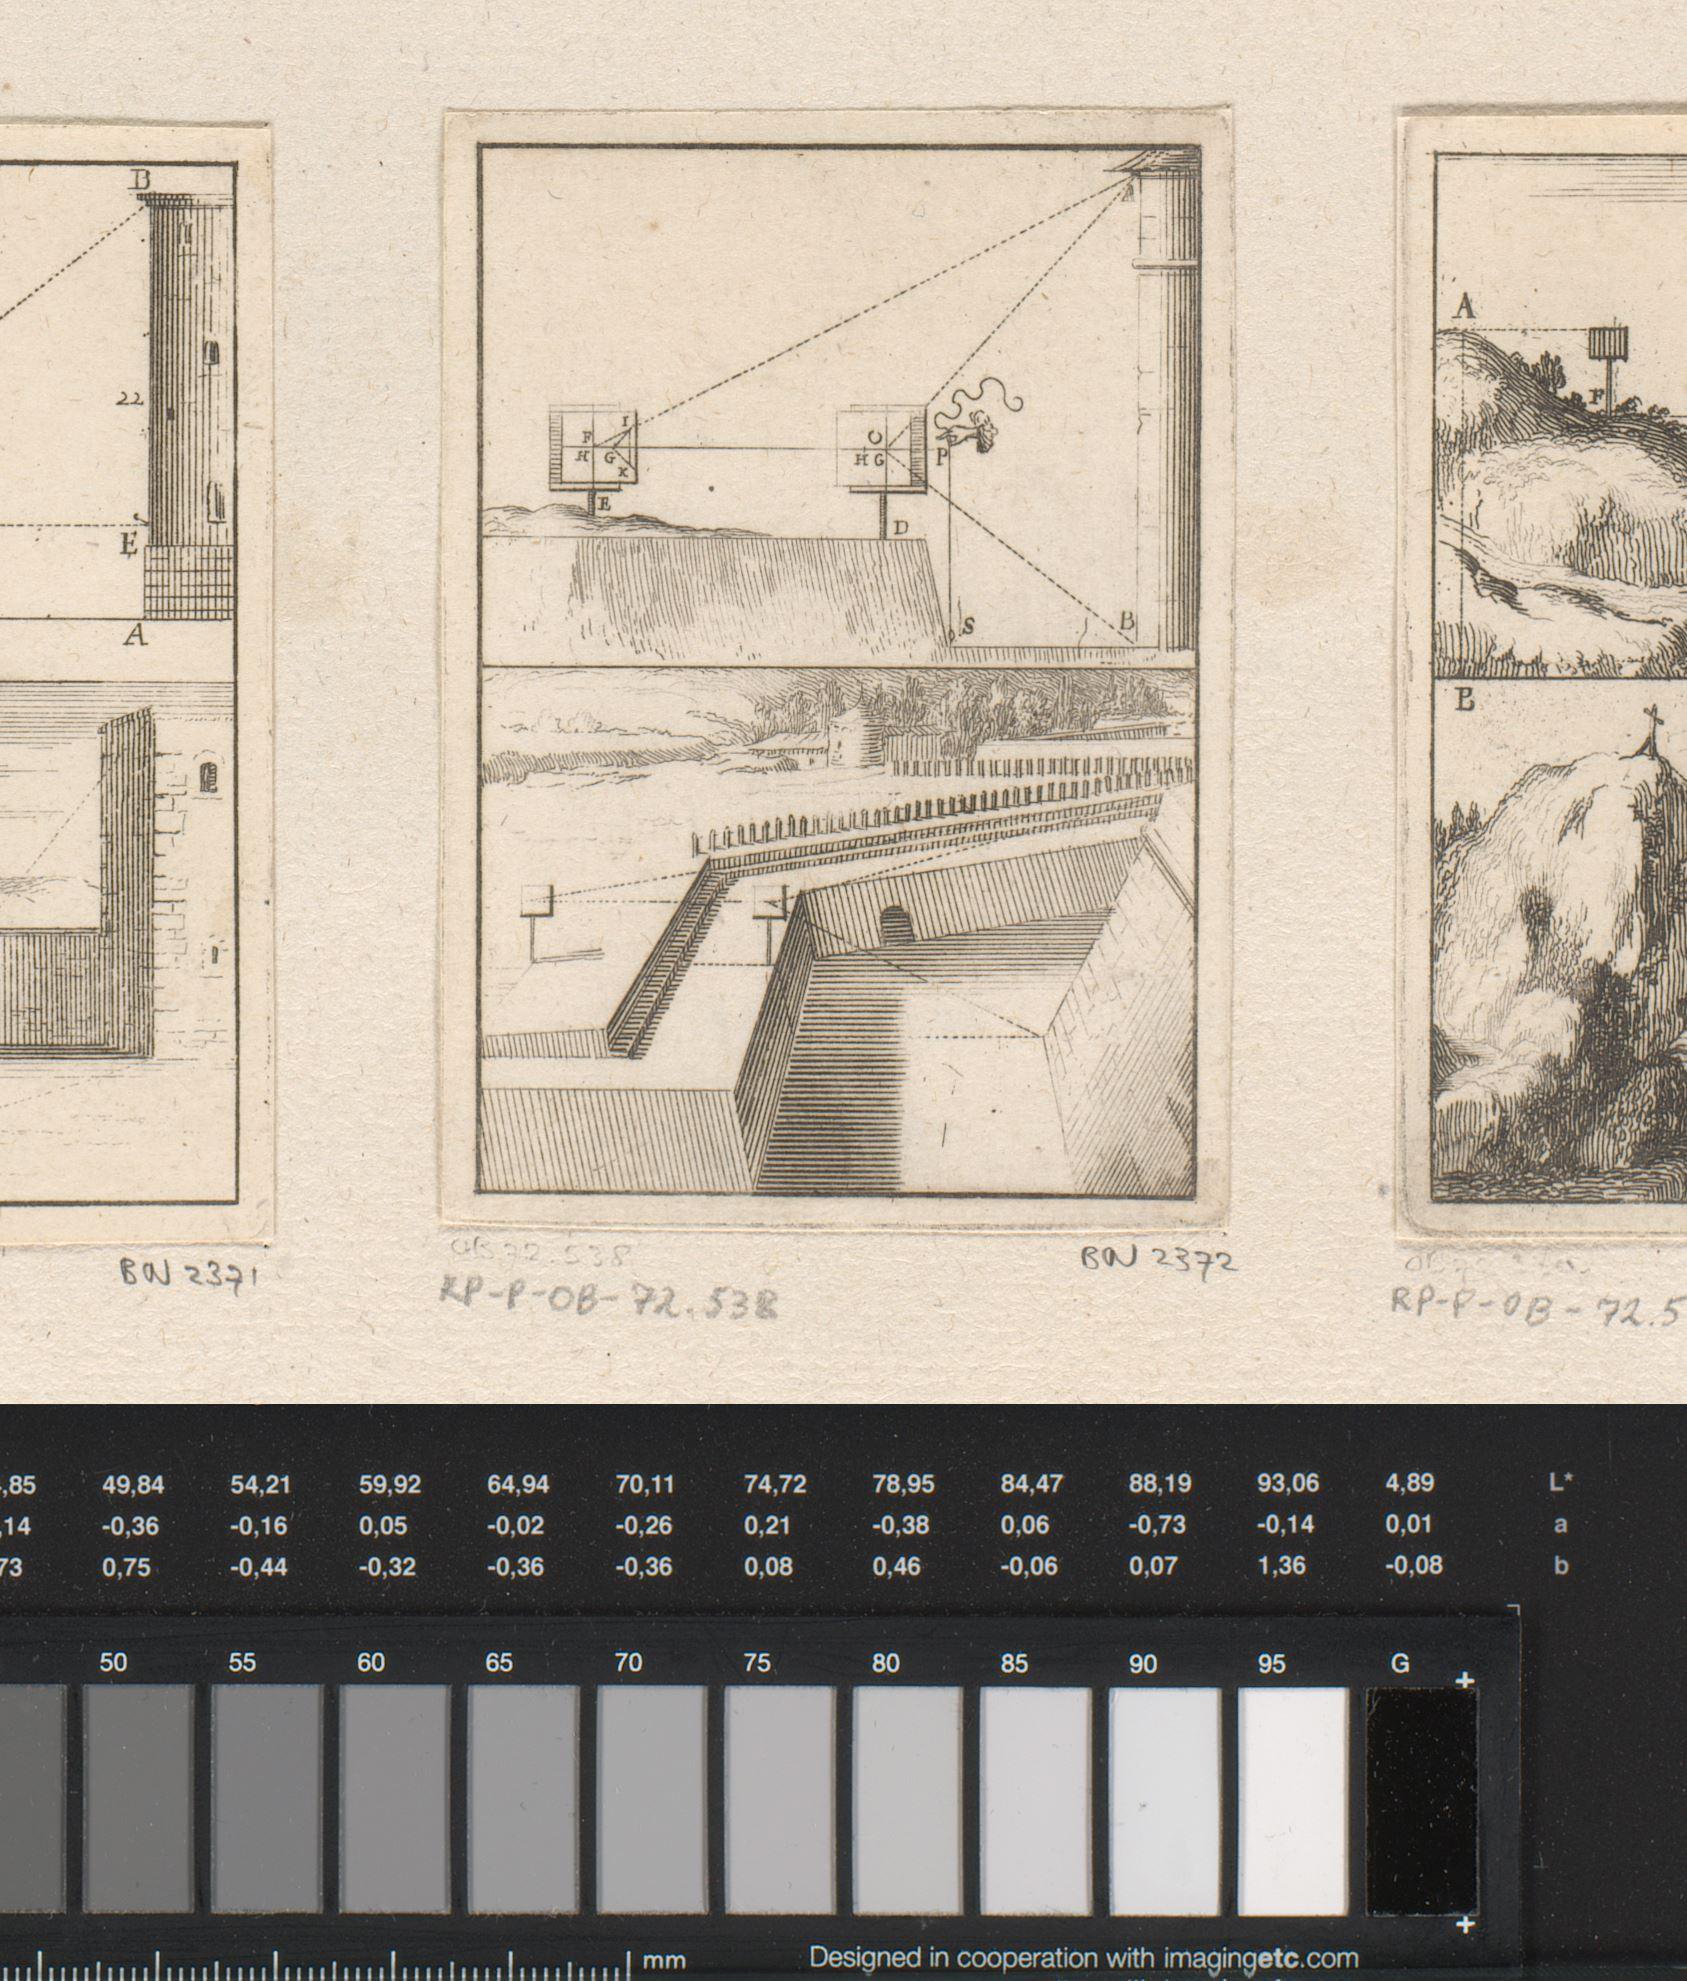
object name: print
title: Opmeten van de hoogte van een toren vanaf een oneffen terrein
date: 1669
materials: paper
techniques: etching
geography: france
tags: tower, clock tower ~ monumental adornment, planimetry, geometry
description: Prent toegevoegd aan: Pratique de la géometrie, sur le papier et sur le terrain. Avec un nouvel ordre et une méthode particulière. Parijs: Thomas Jolly, 1669.